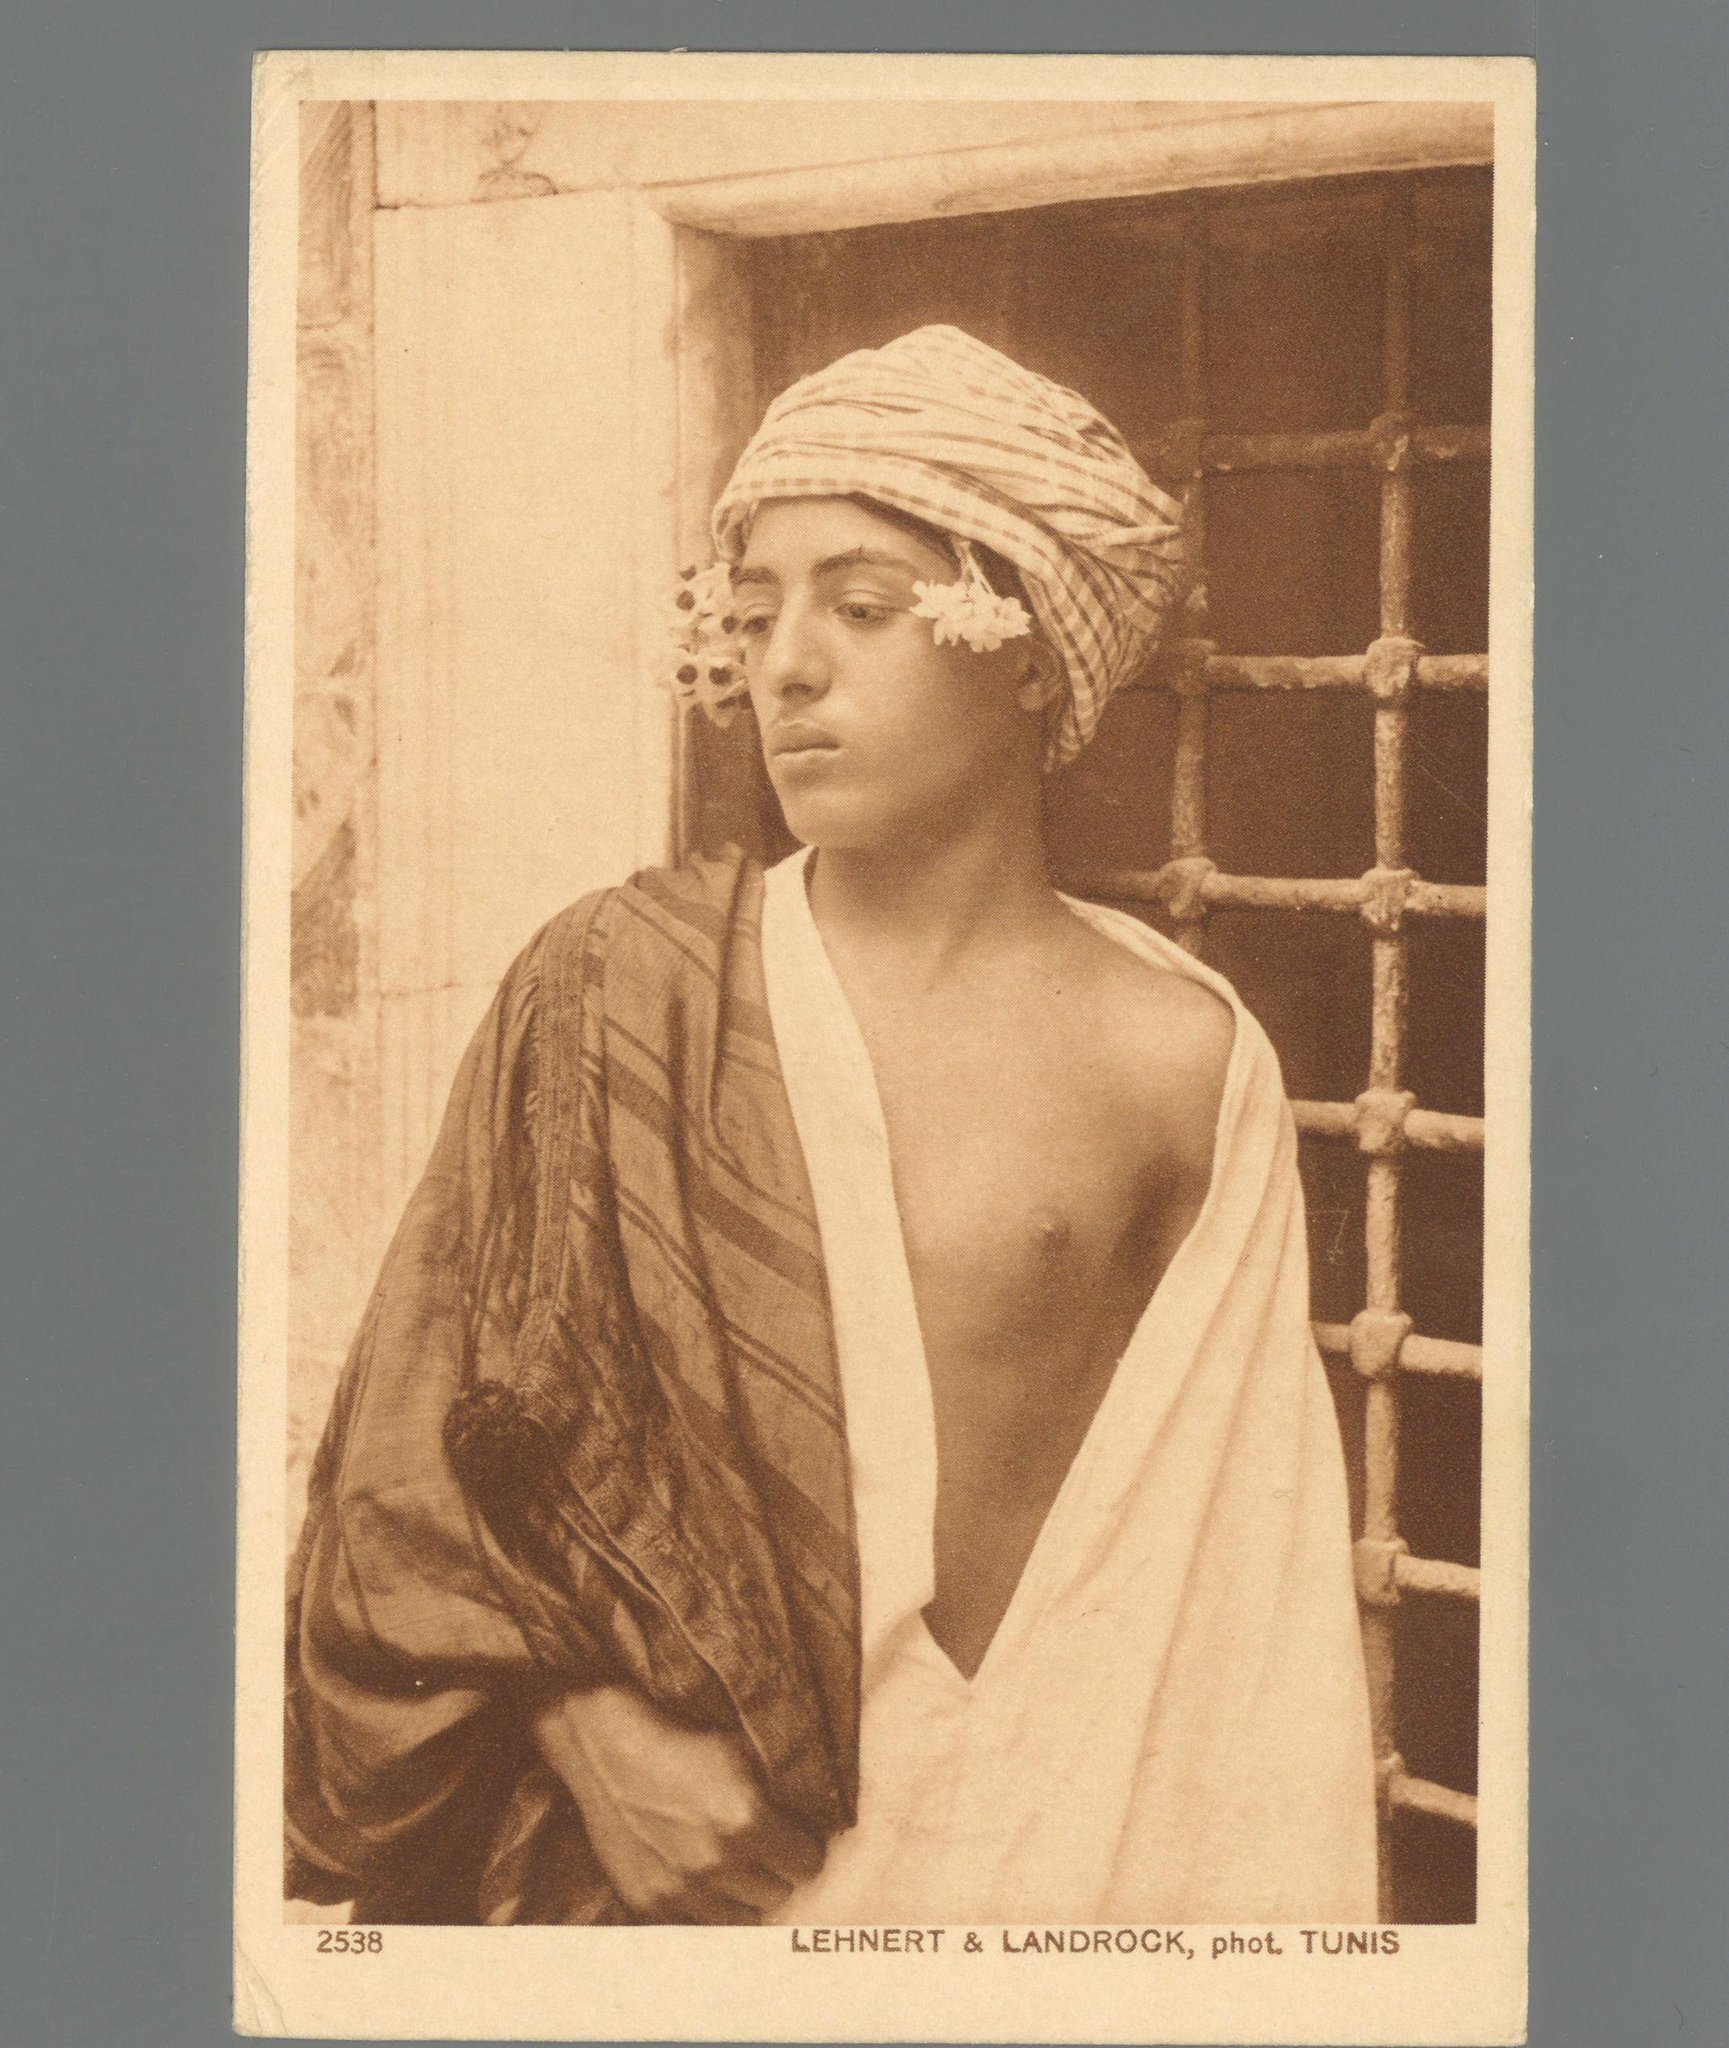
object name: photomechanical print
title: Jeune arabe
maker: Anonymous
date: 1903-1930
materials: cardboard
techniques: rotogravure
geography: tunis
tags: head-gear: turban, historical persons (portraits and scenes from the life)